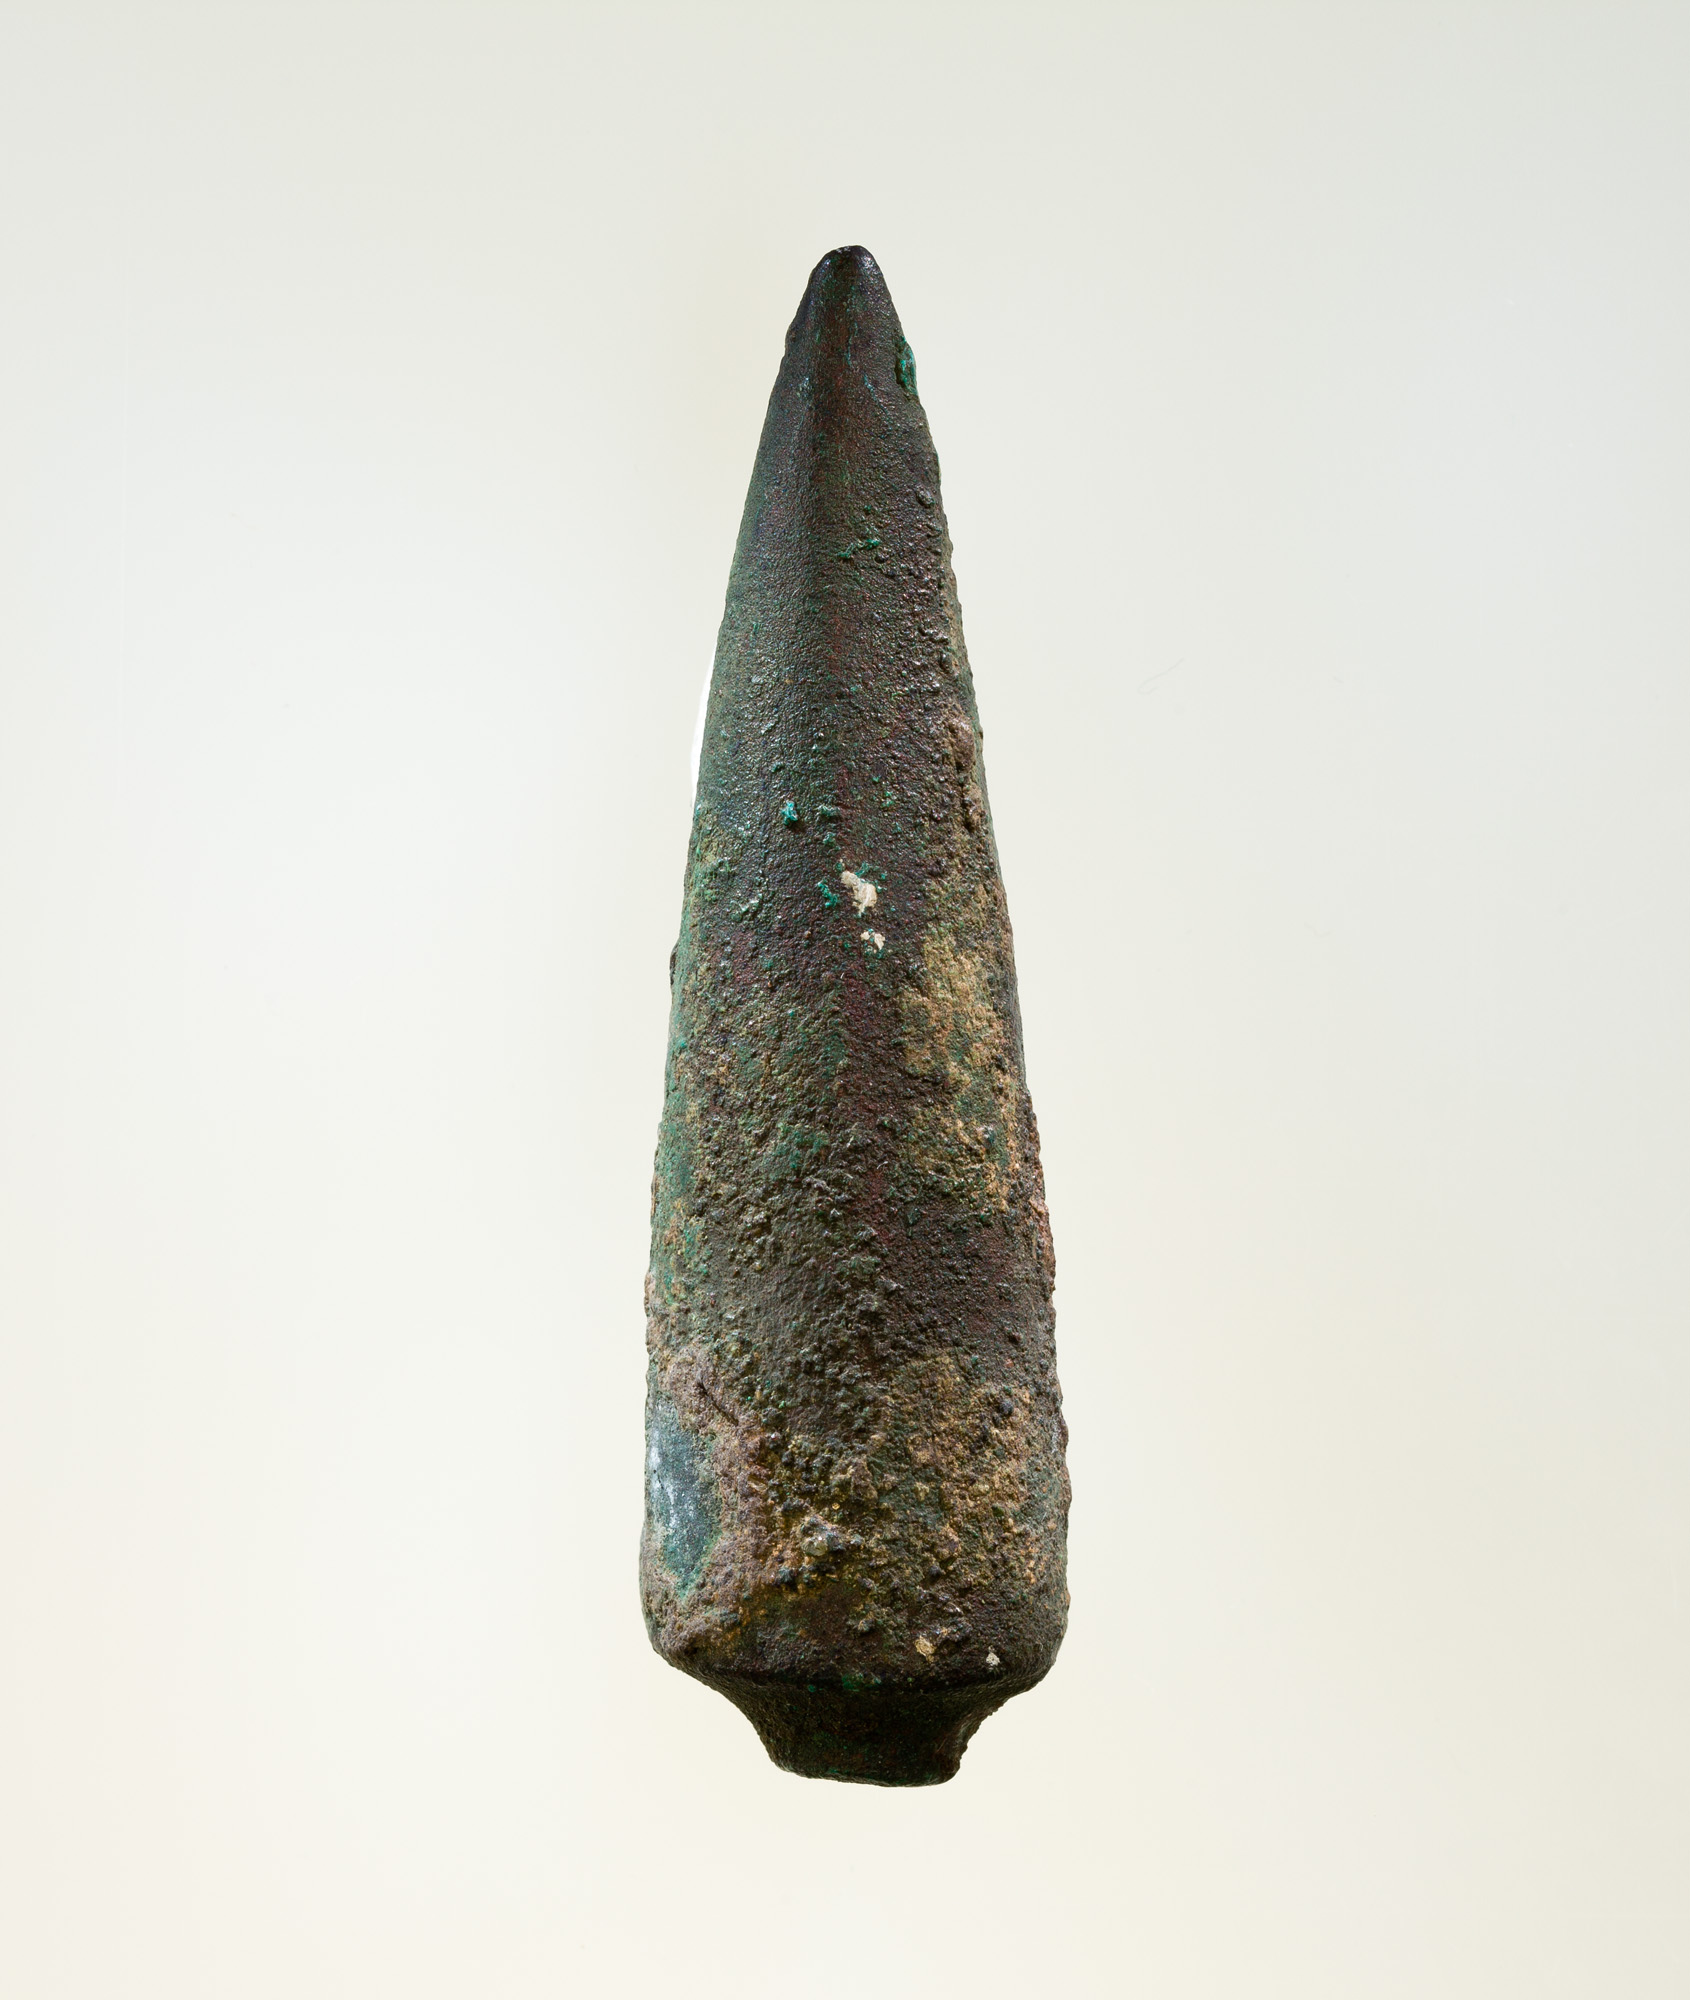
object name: ornament, lotus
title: Lotus ornament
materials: copper alloy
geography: egypt